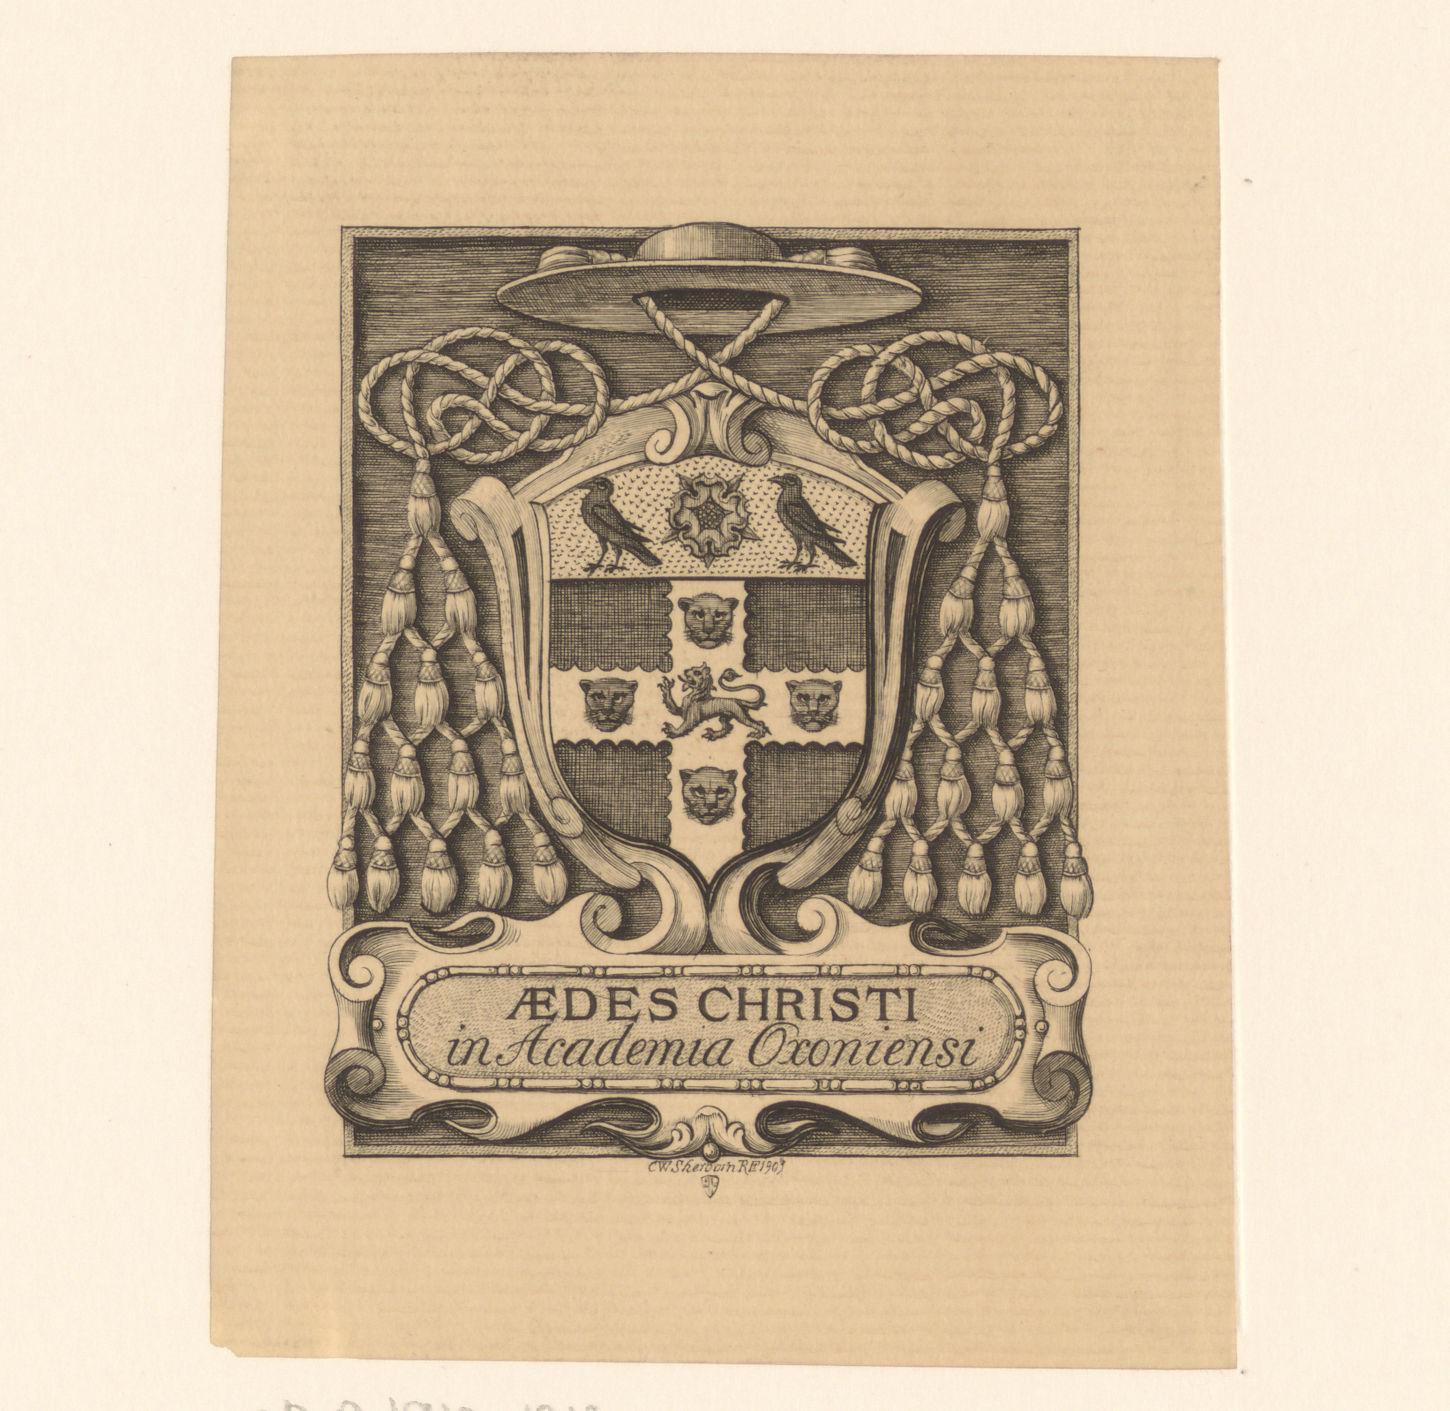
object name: bookplate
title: Aedes Christi in Academia Oxoniensi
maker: charles william sherborn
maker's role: print maker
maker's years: 1831-1912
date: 1903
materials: paper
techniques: engraving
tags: foliage ~ ornament, insignia of cardinal, e.g. hat, mantle, armorial bearing, heraldry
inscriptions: collector's mark: Lugt 2228